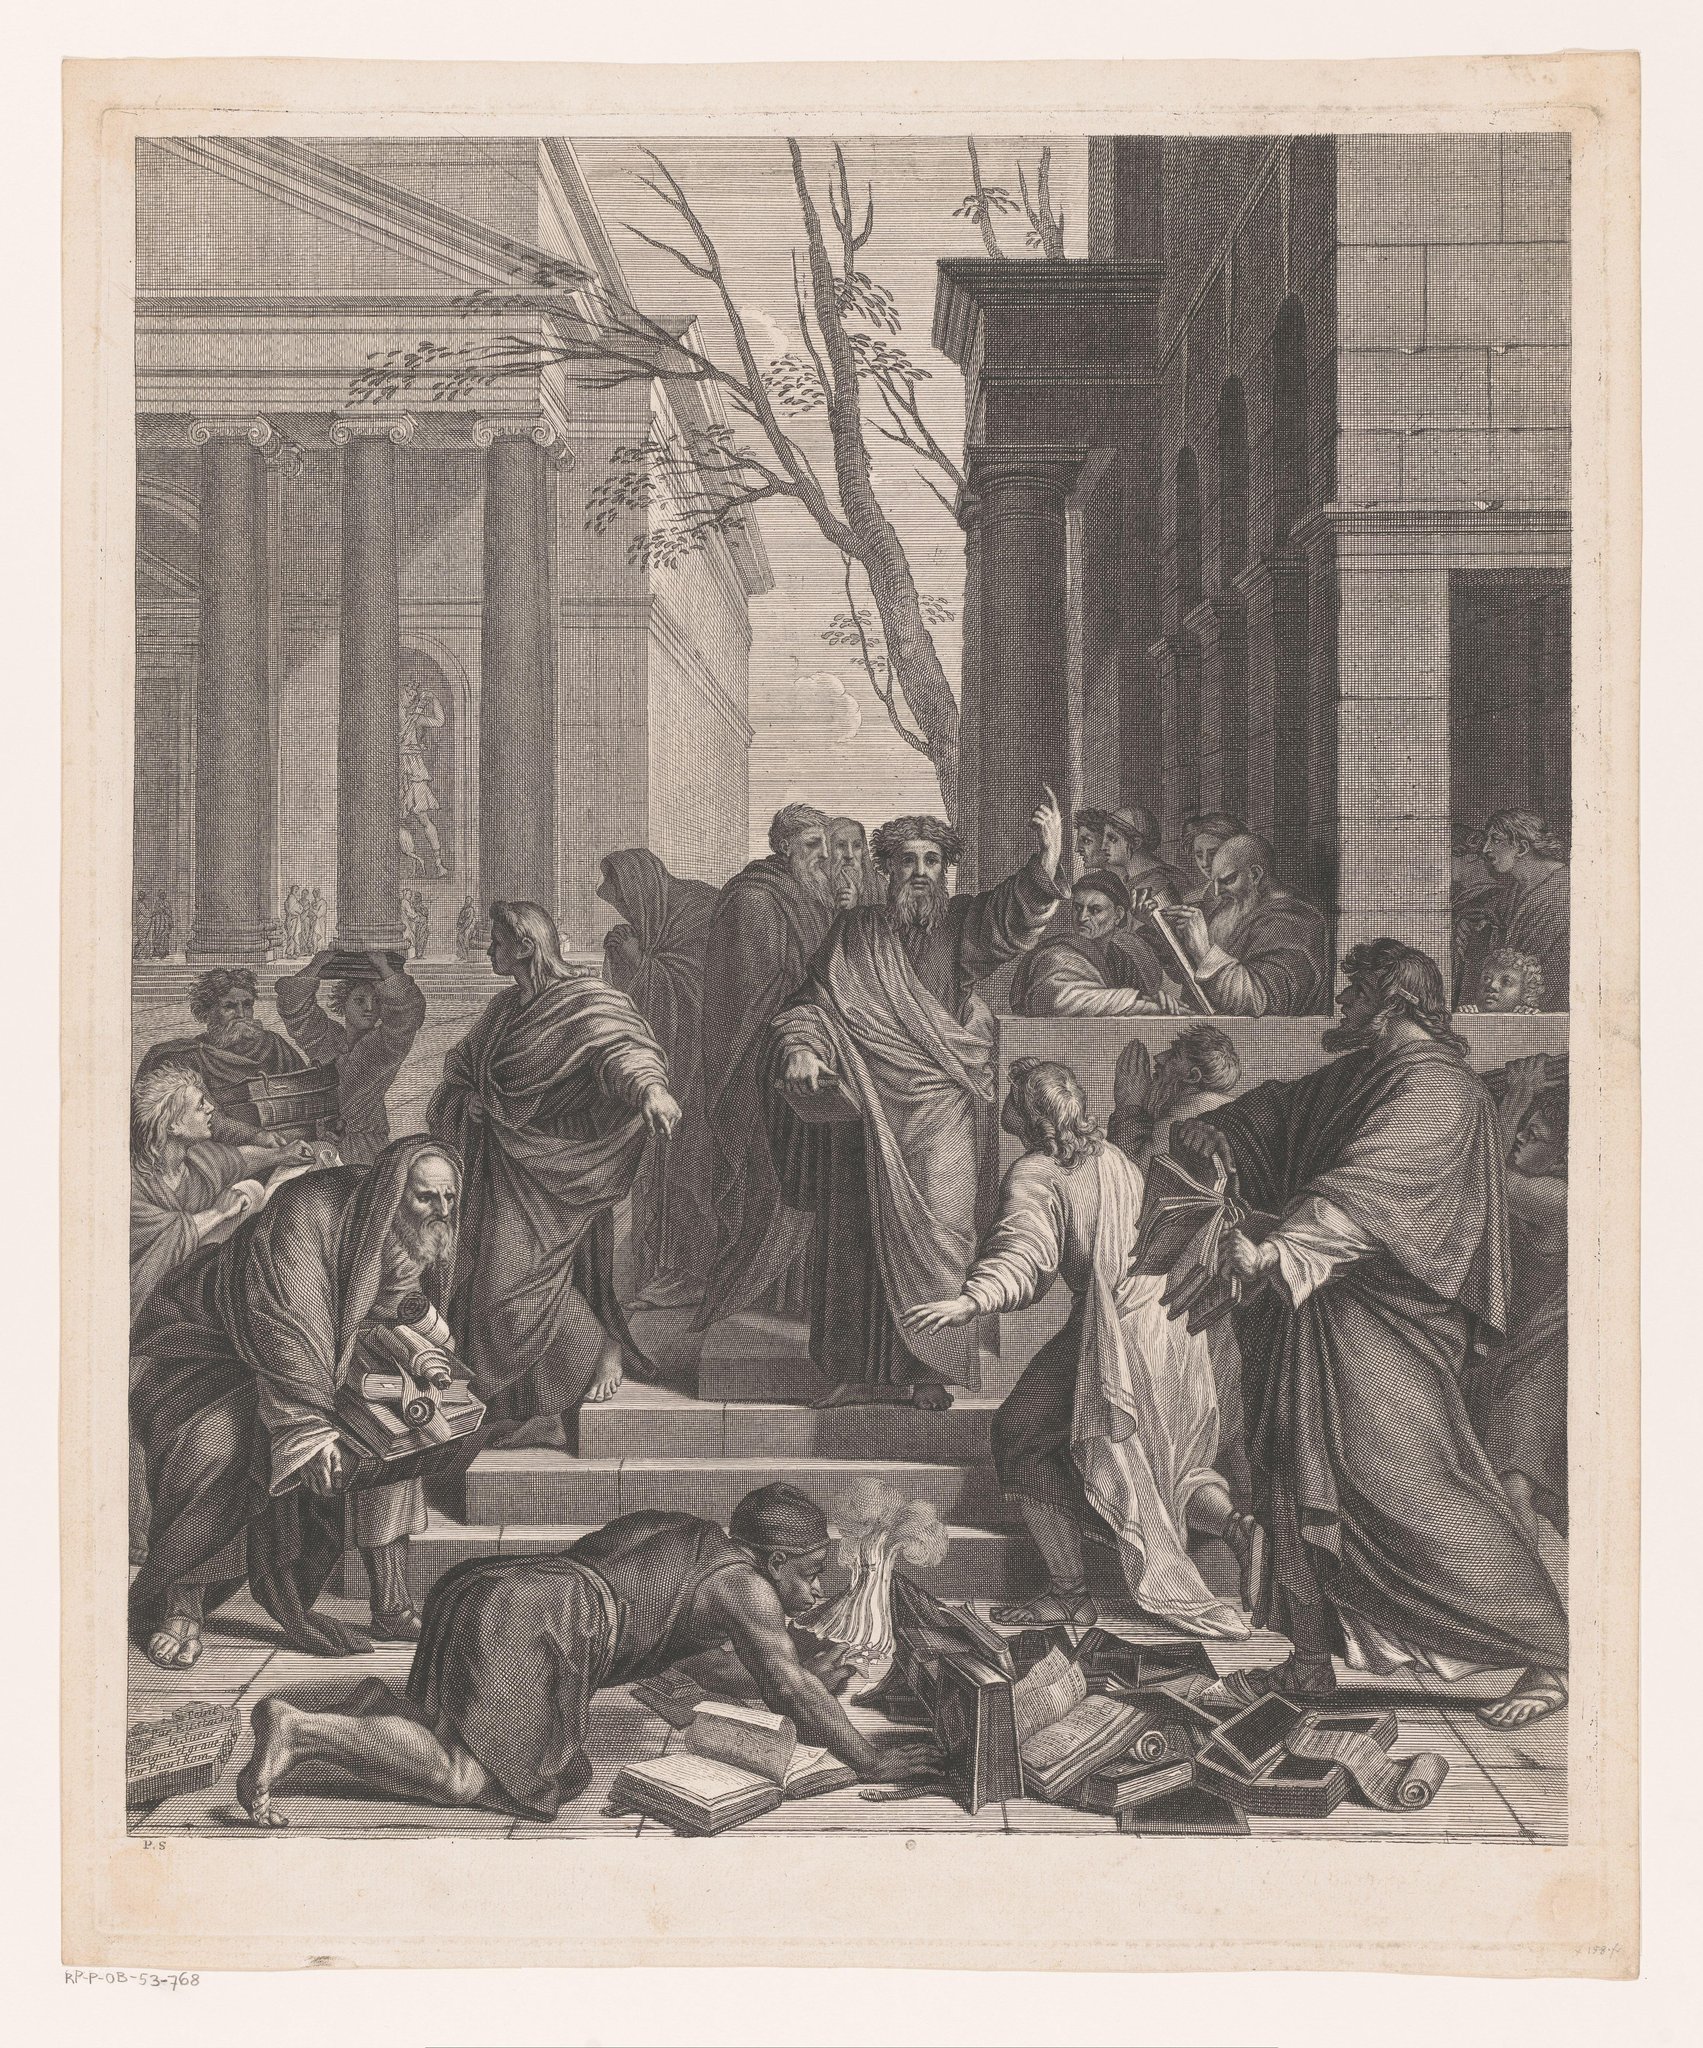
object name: print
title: Prediking van Paulus te Ephese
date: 1686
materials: paper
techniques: engraving, etching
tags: the ephesians burn the exorcists' books in public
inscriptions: collector's mark: Lugt 2228, collector's mark: Lugt 2760